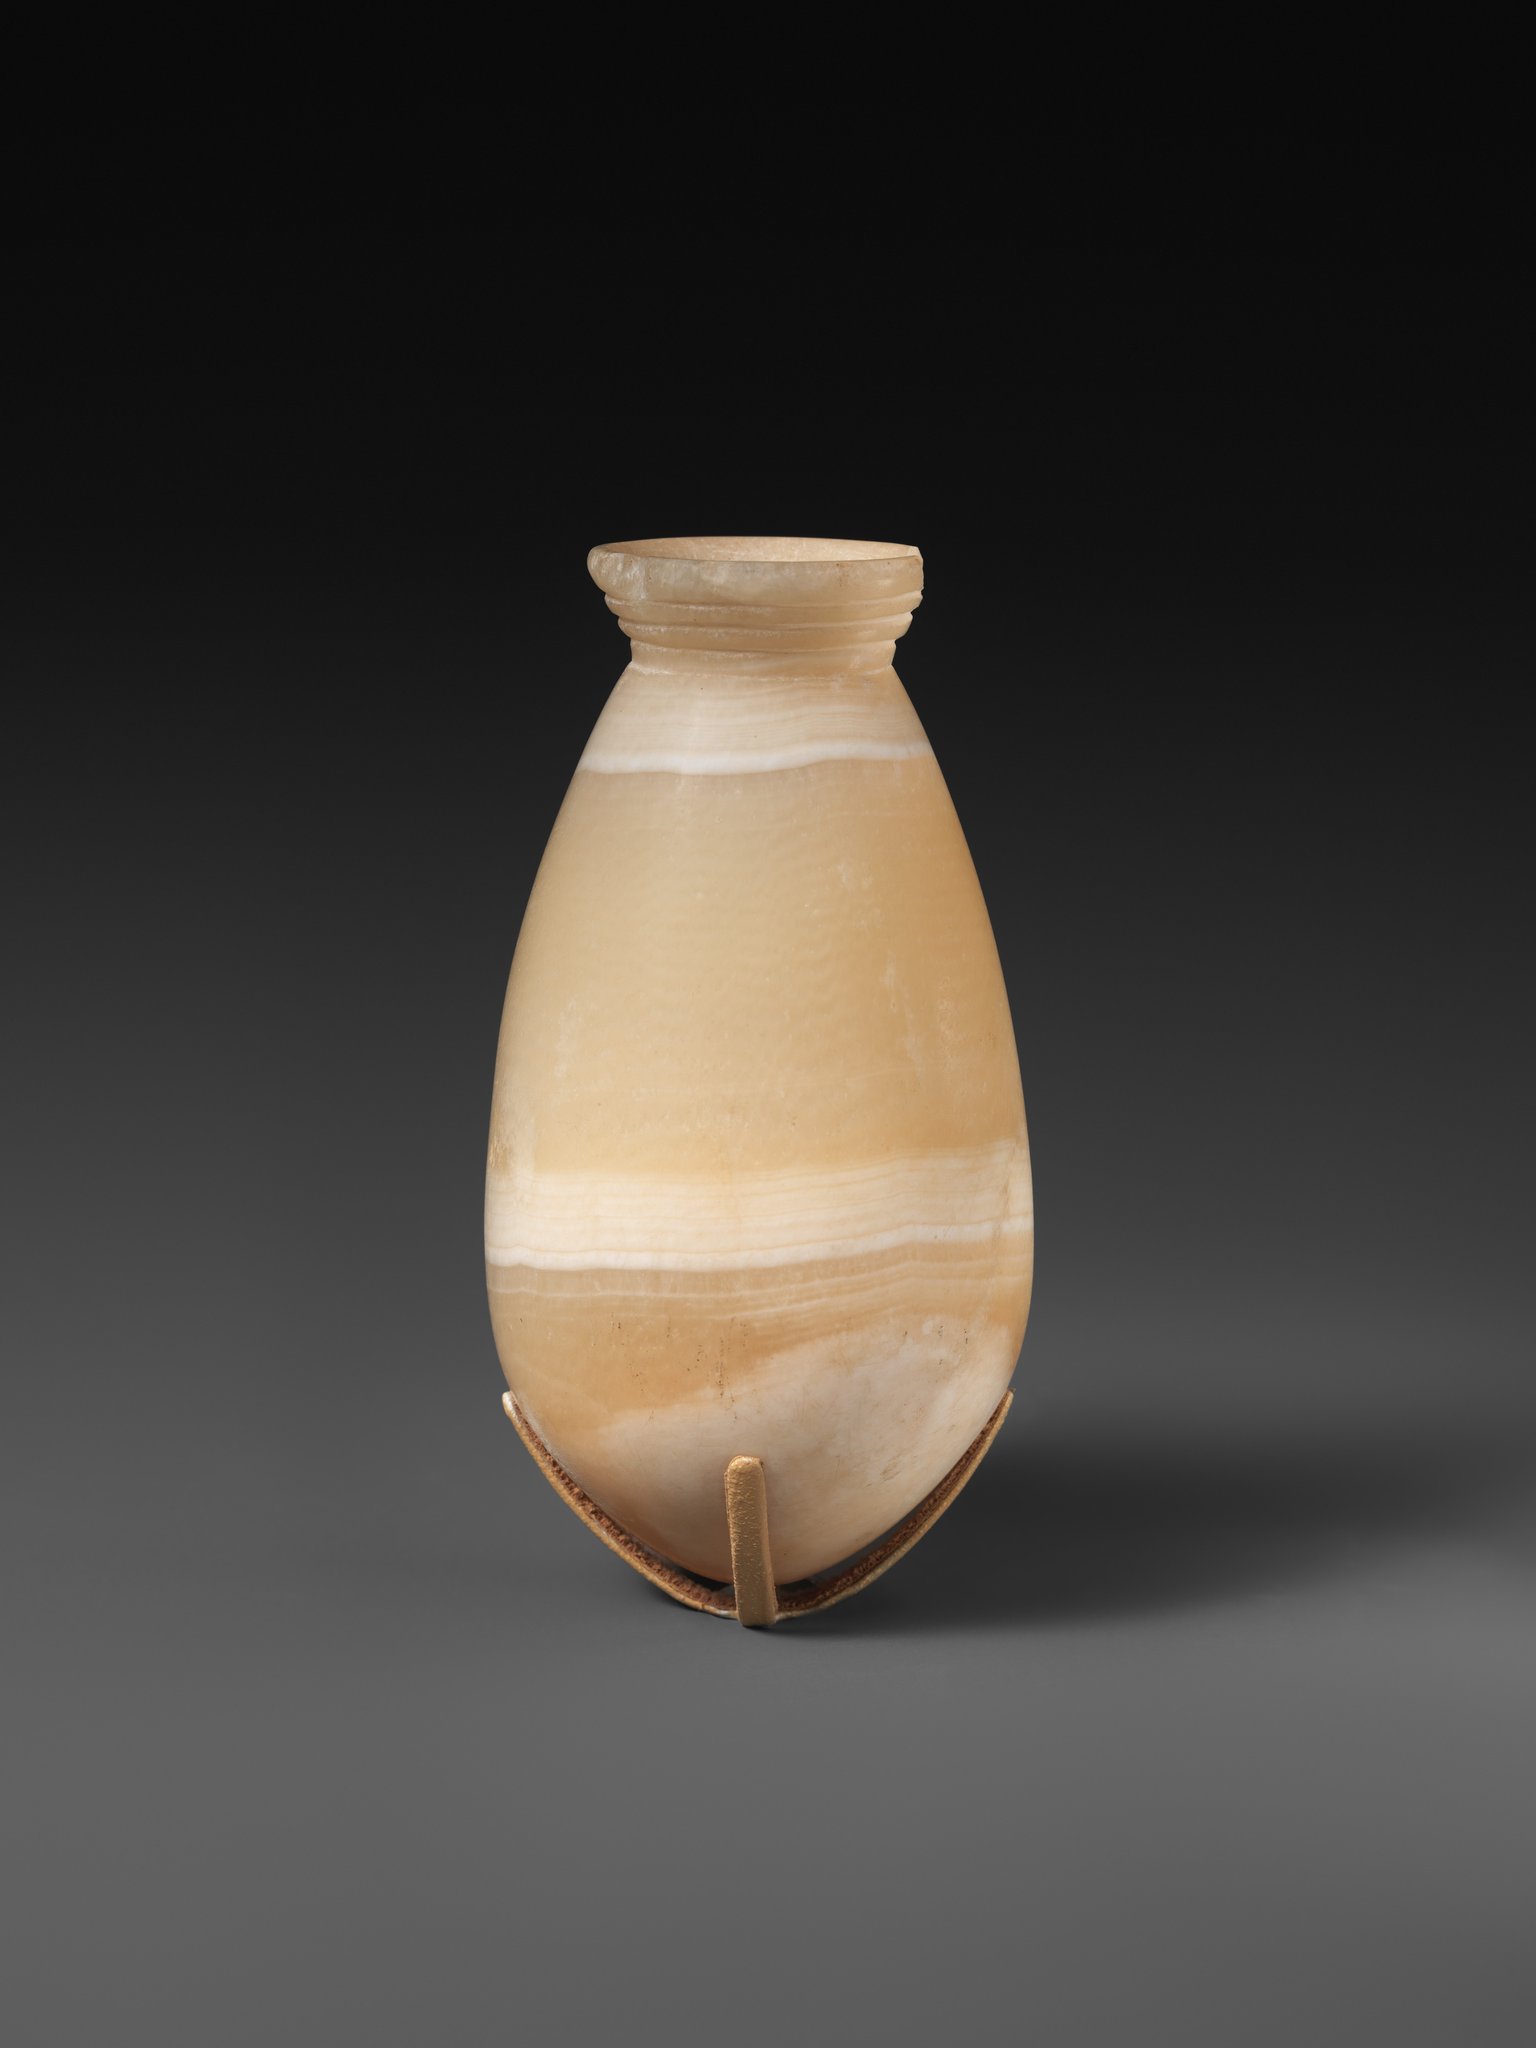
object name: bag shaped jar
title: Bag-shaped jar with ridged neck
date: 1887-1750 BCE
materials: stone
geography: egypt